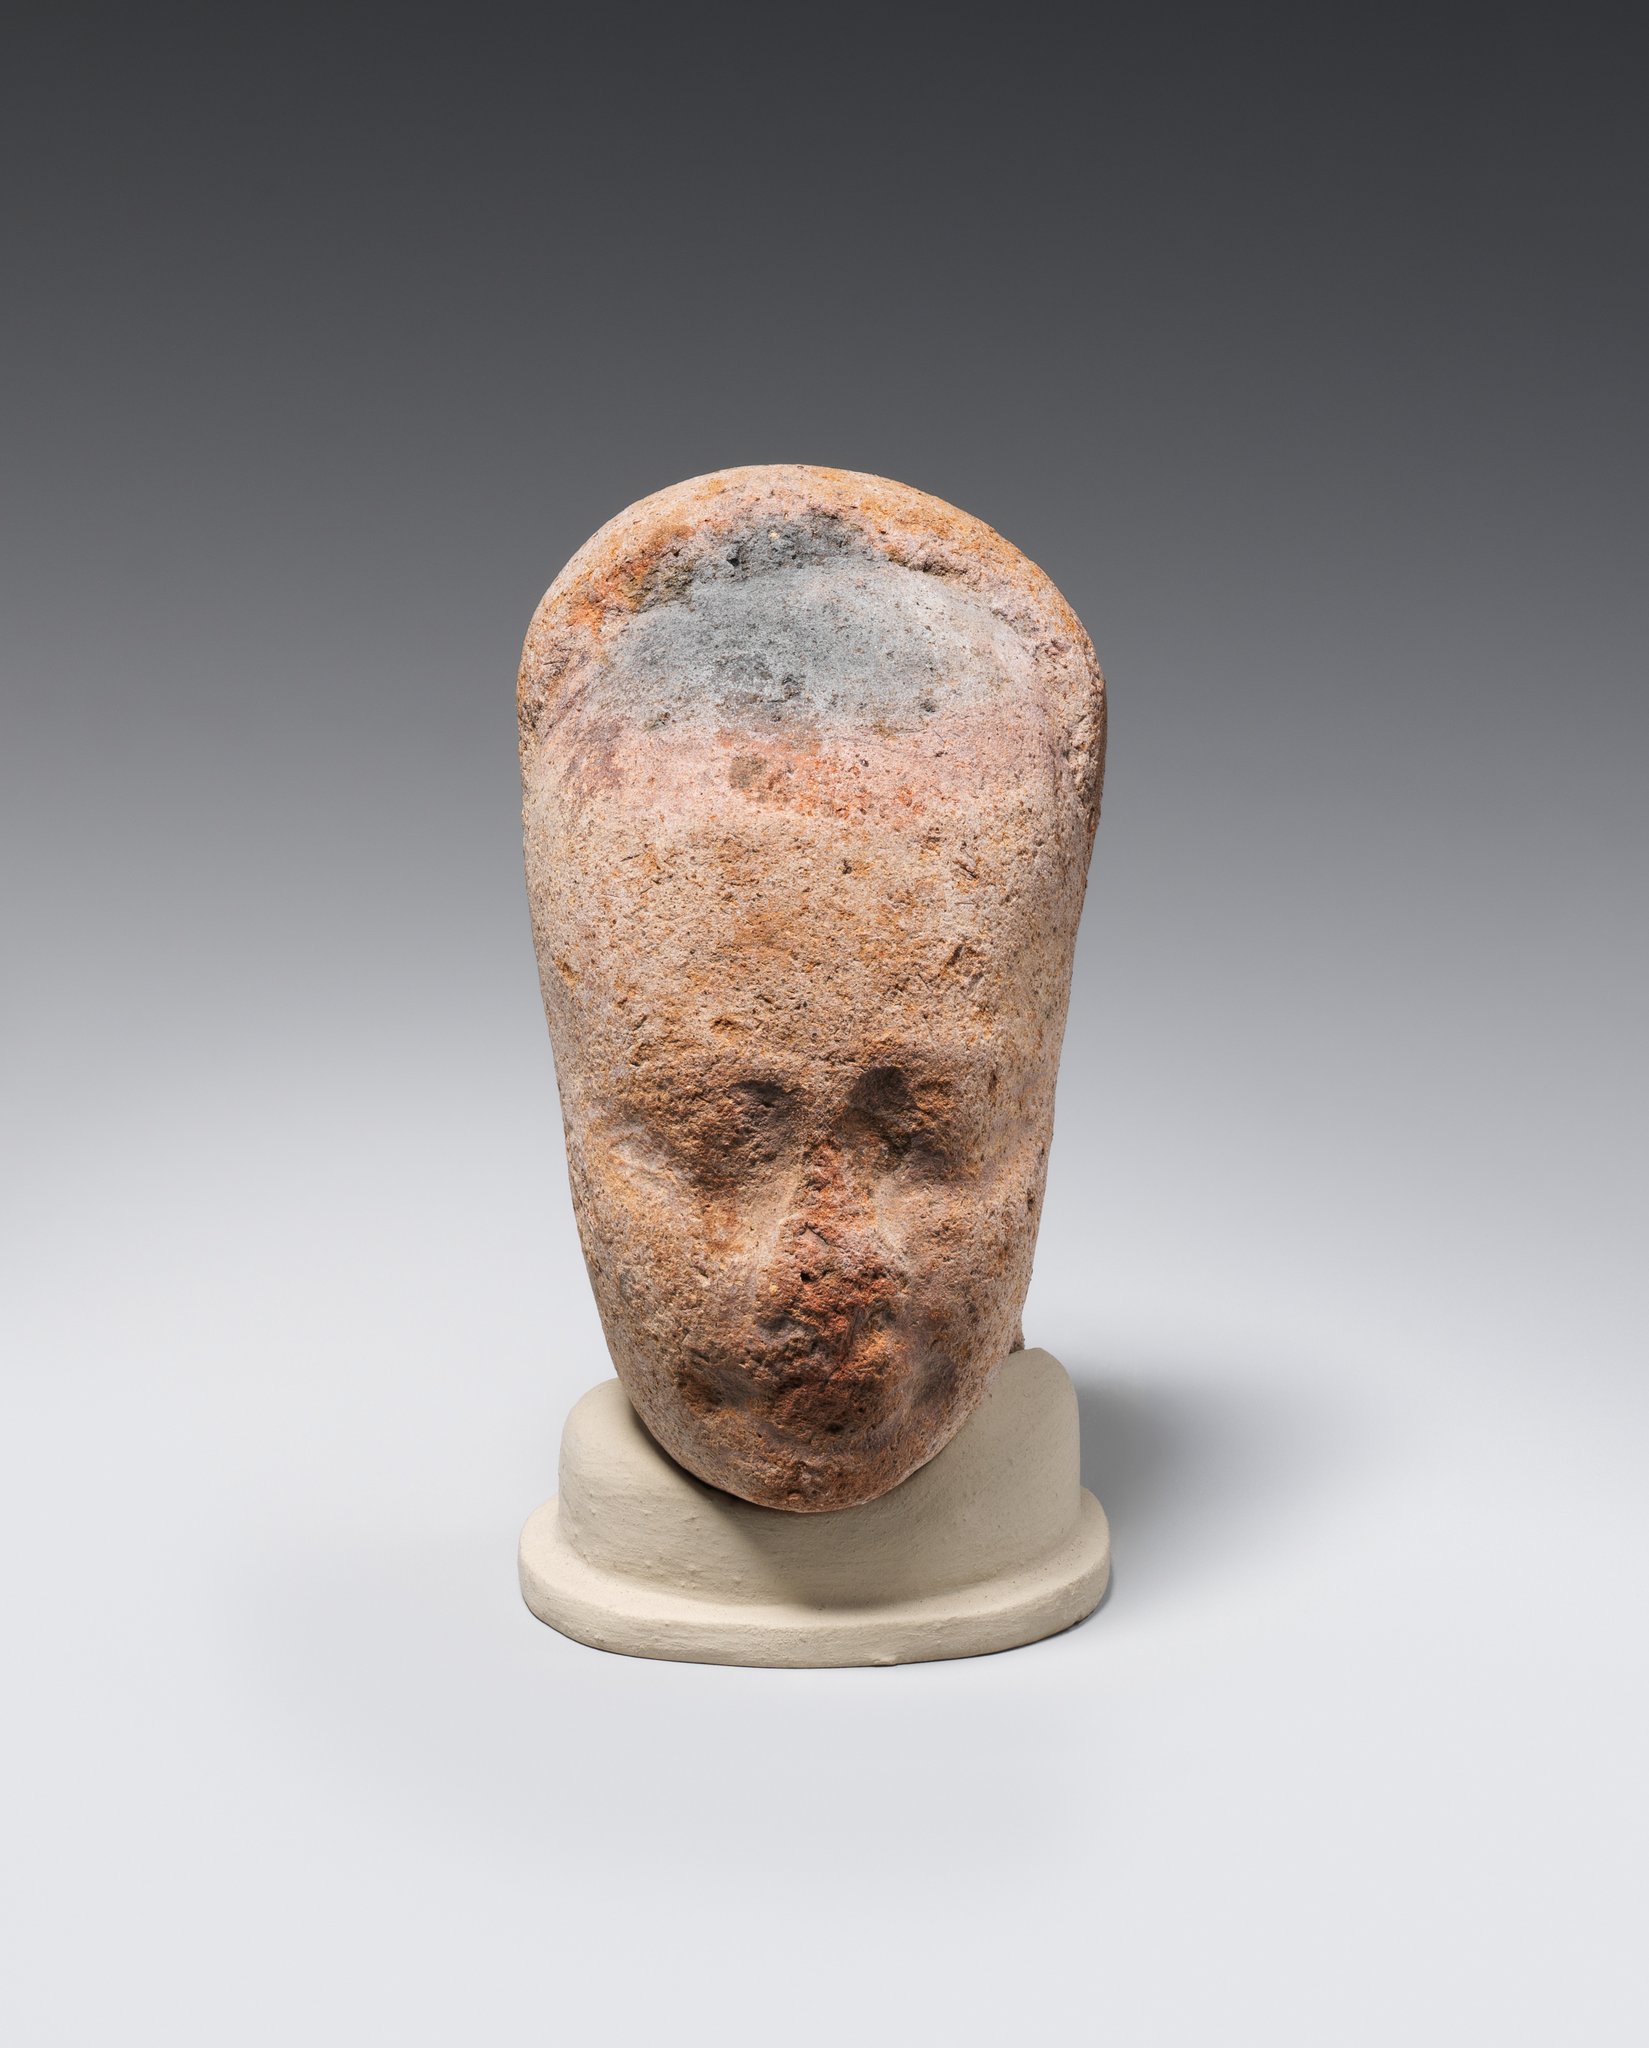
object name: head, female statue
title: Head of female figure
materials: pottery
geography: egypt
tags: heads,women